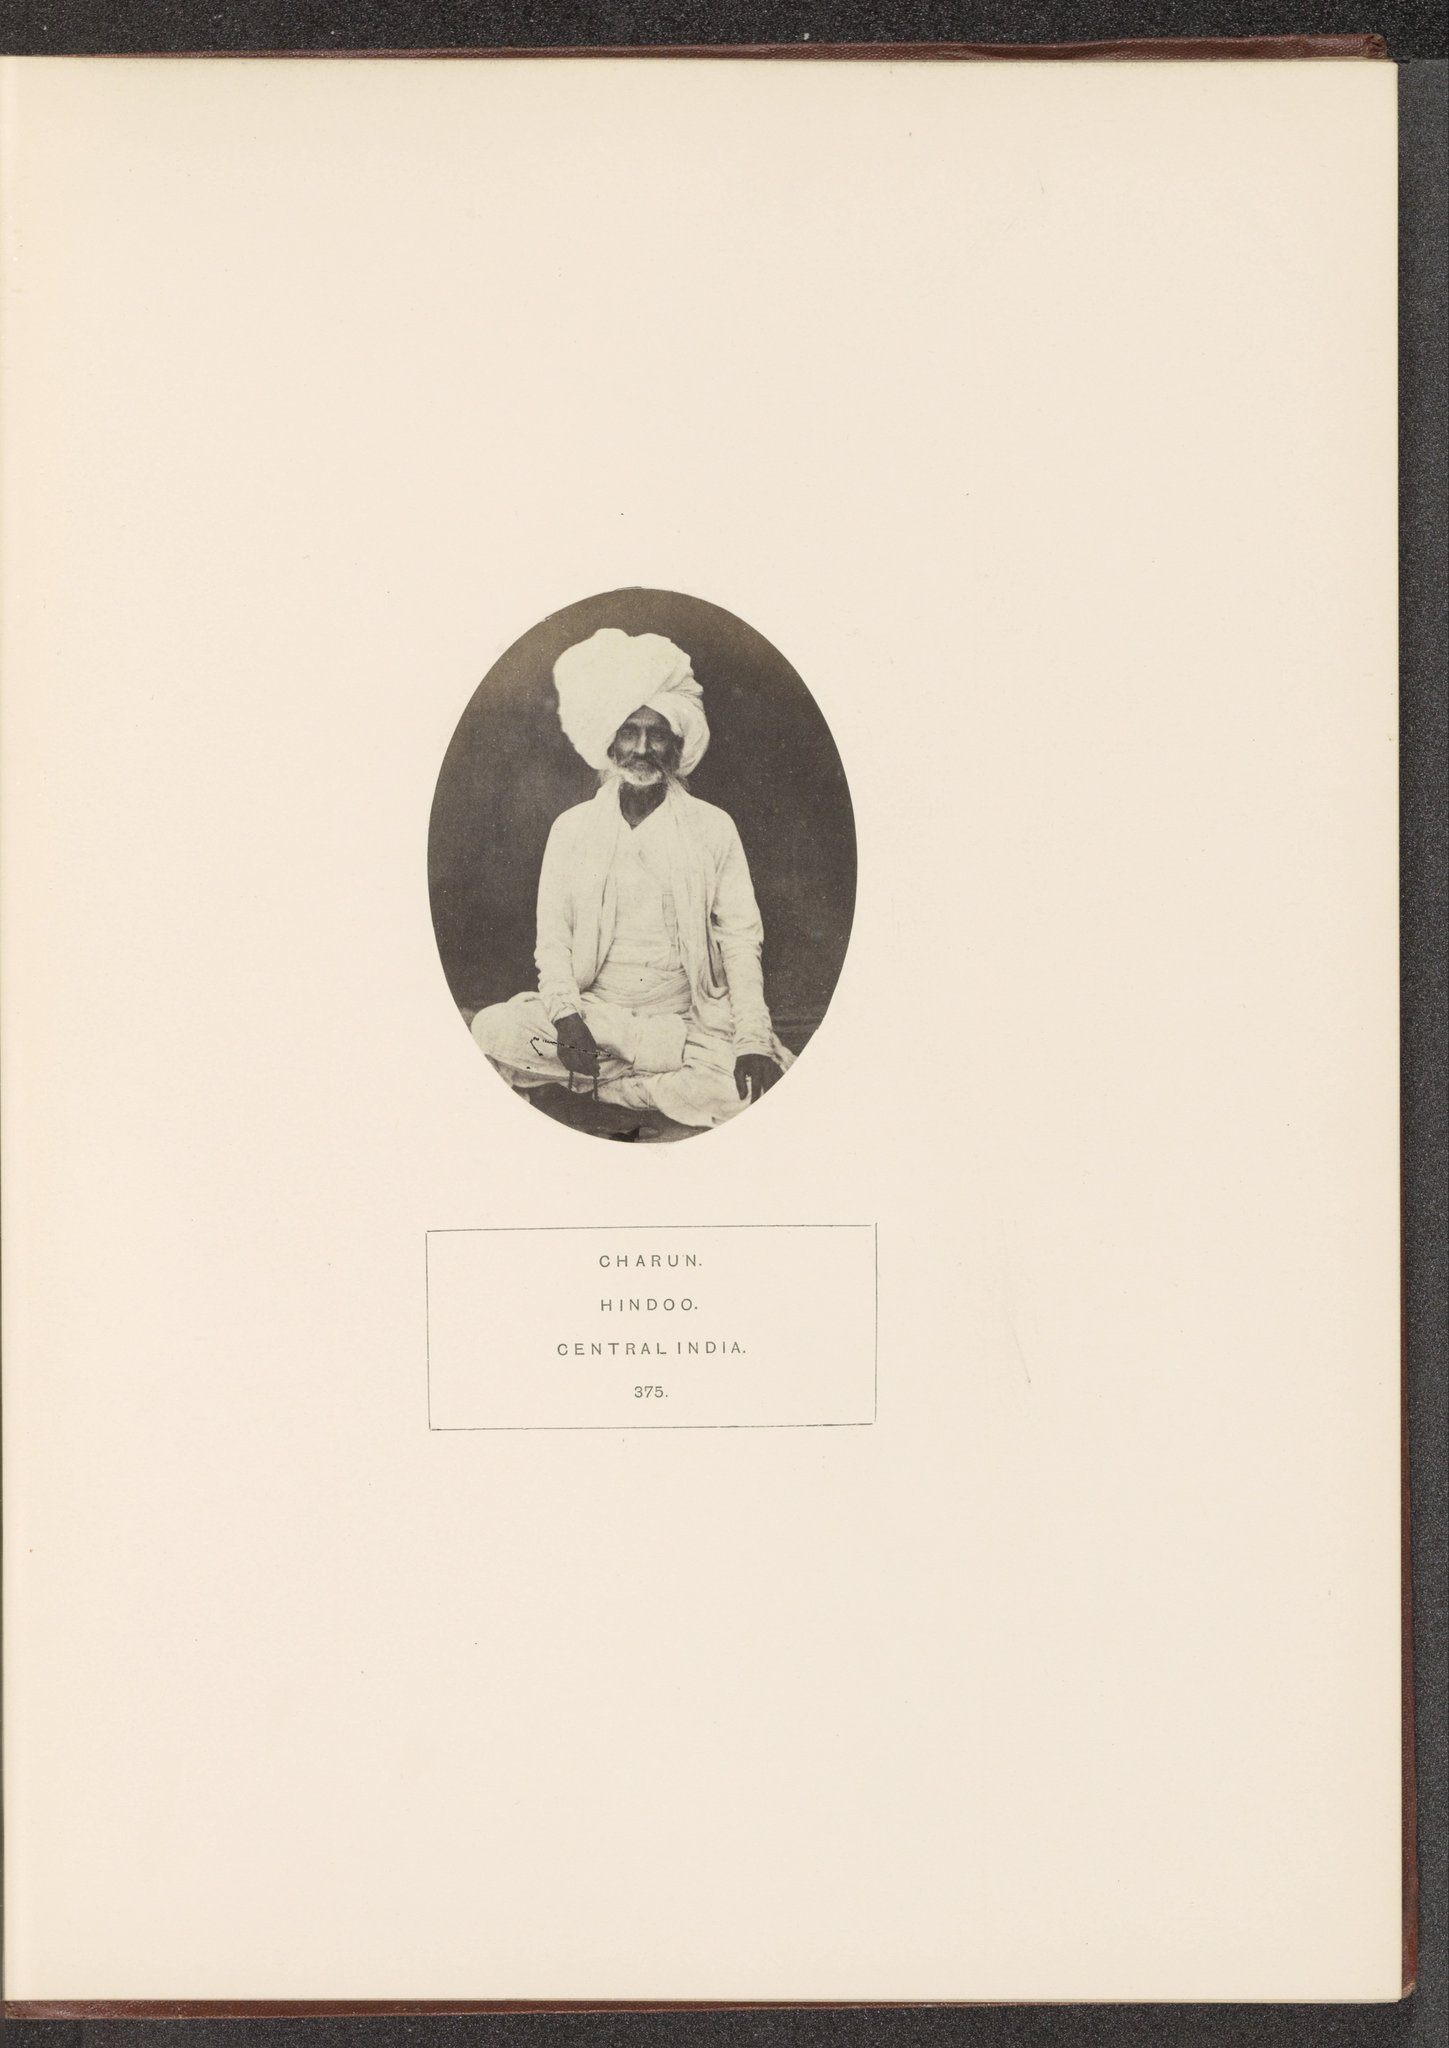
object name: photograph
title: Portrait of an unknown man from the Charan community with a turban, Madhya Pradesh, India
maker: james john waterhouse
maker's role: fotograaf, luitenant, officier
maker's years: 1842-1928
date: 1862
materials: photographic support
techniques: albumen print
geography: india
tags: head-gear: turban, human races; peoples; nationalities, religious functionaries ~ hinduism, buddhism, jainism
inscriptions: number: ‘375.’, inscription: ‘CHARUN./ HINDOO./ CENTRAL INDIA.’